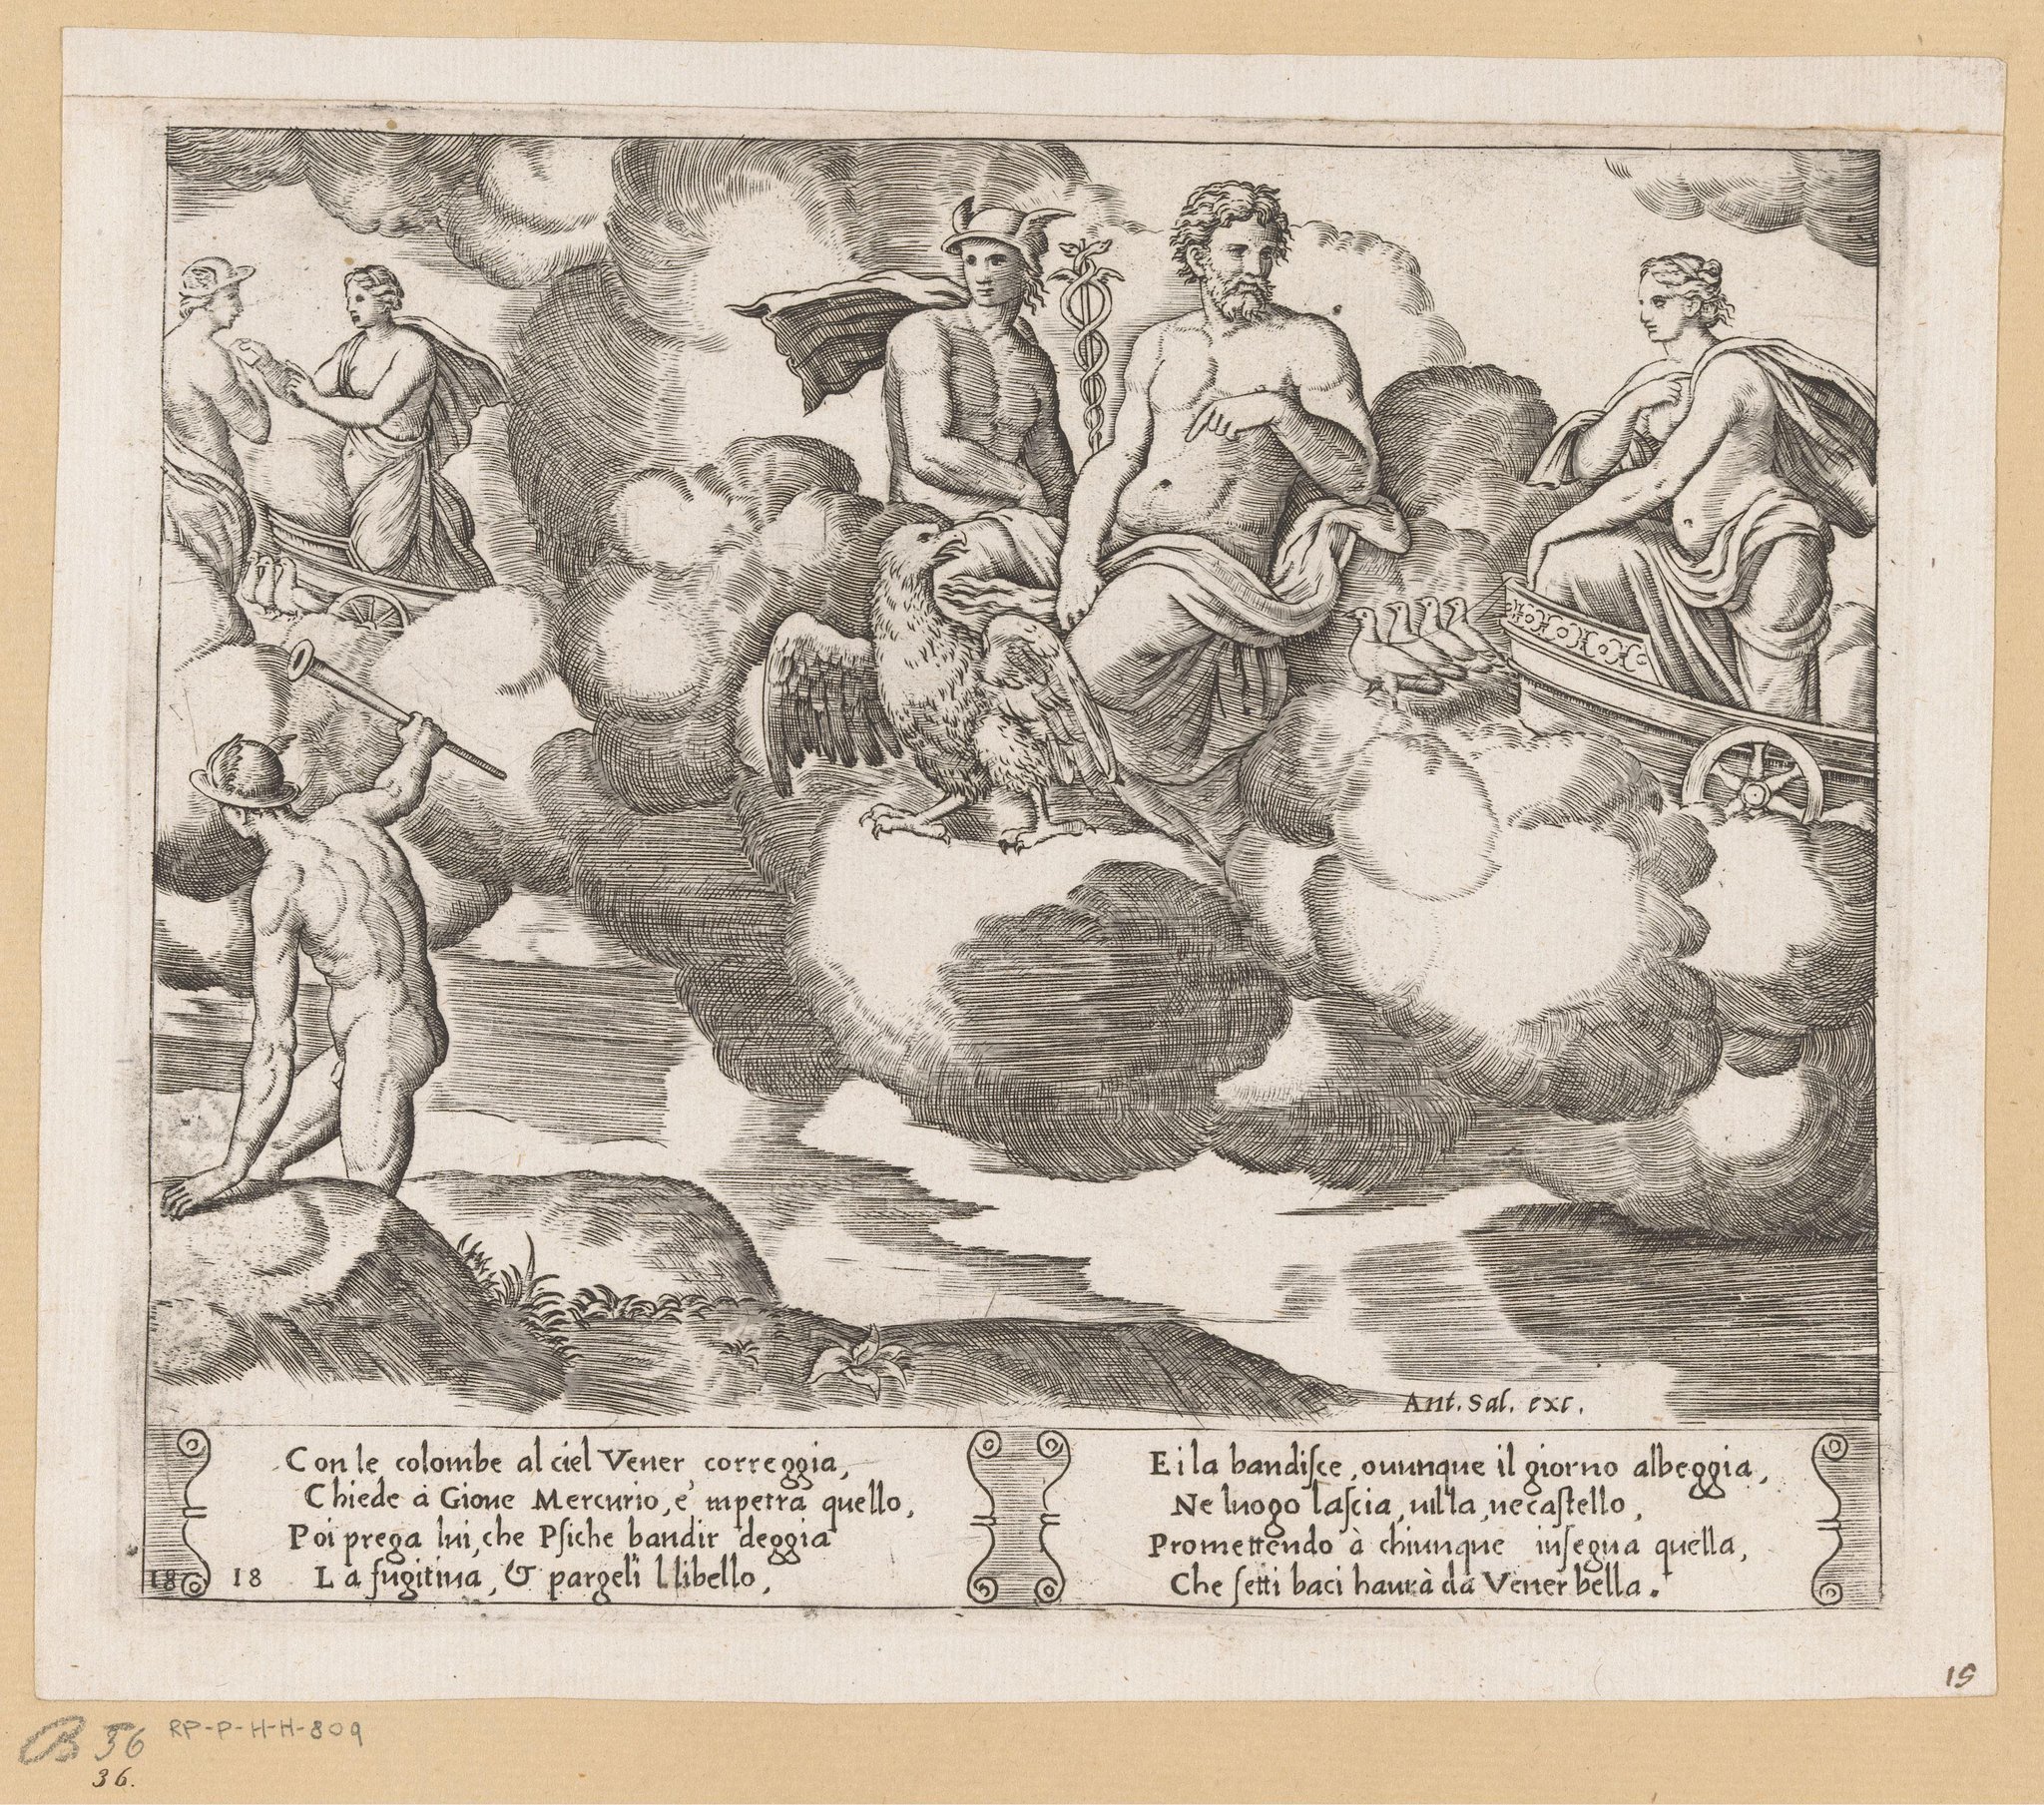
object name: print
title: Verhaal van Amor en Psyche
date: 1530-1560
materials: paper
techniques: engraving, intaglio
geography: rome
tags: (story of) mercury (hermes), (story of) jupiter (zeus), other scenes from the story of cupid and psyche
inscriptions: number: ‘19’, collector's mark: Lugt 11, collector's mark: ‘Hinloopen’, collector's mark: Lugt 10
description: Venus komt aan in haar wagen getrokken door duiven. In het midden zit Jupiter met adelaar en naast hem Mercurius met caduceus. Links Mercurius onderweg en Mercurius in gesprek met Venus. Italiaanse tekst in twee cartouches in ondermarge. Tweemaal genummerd linksonder: 18.